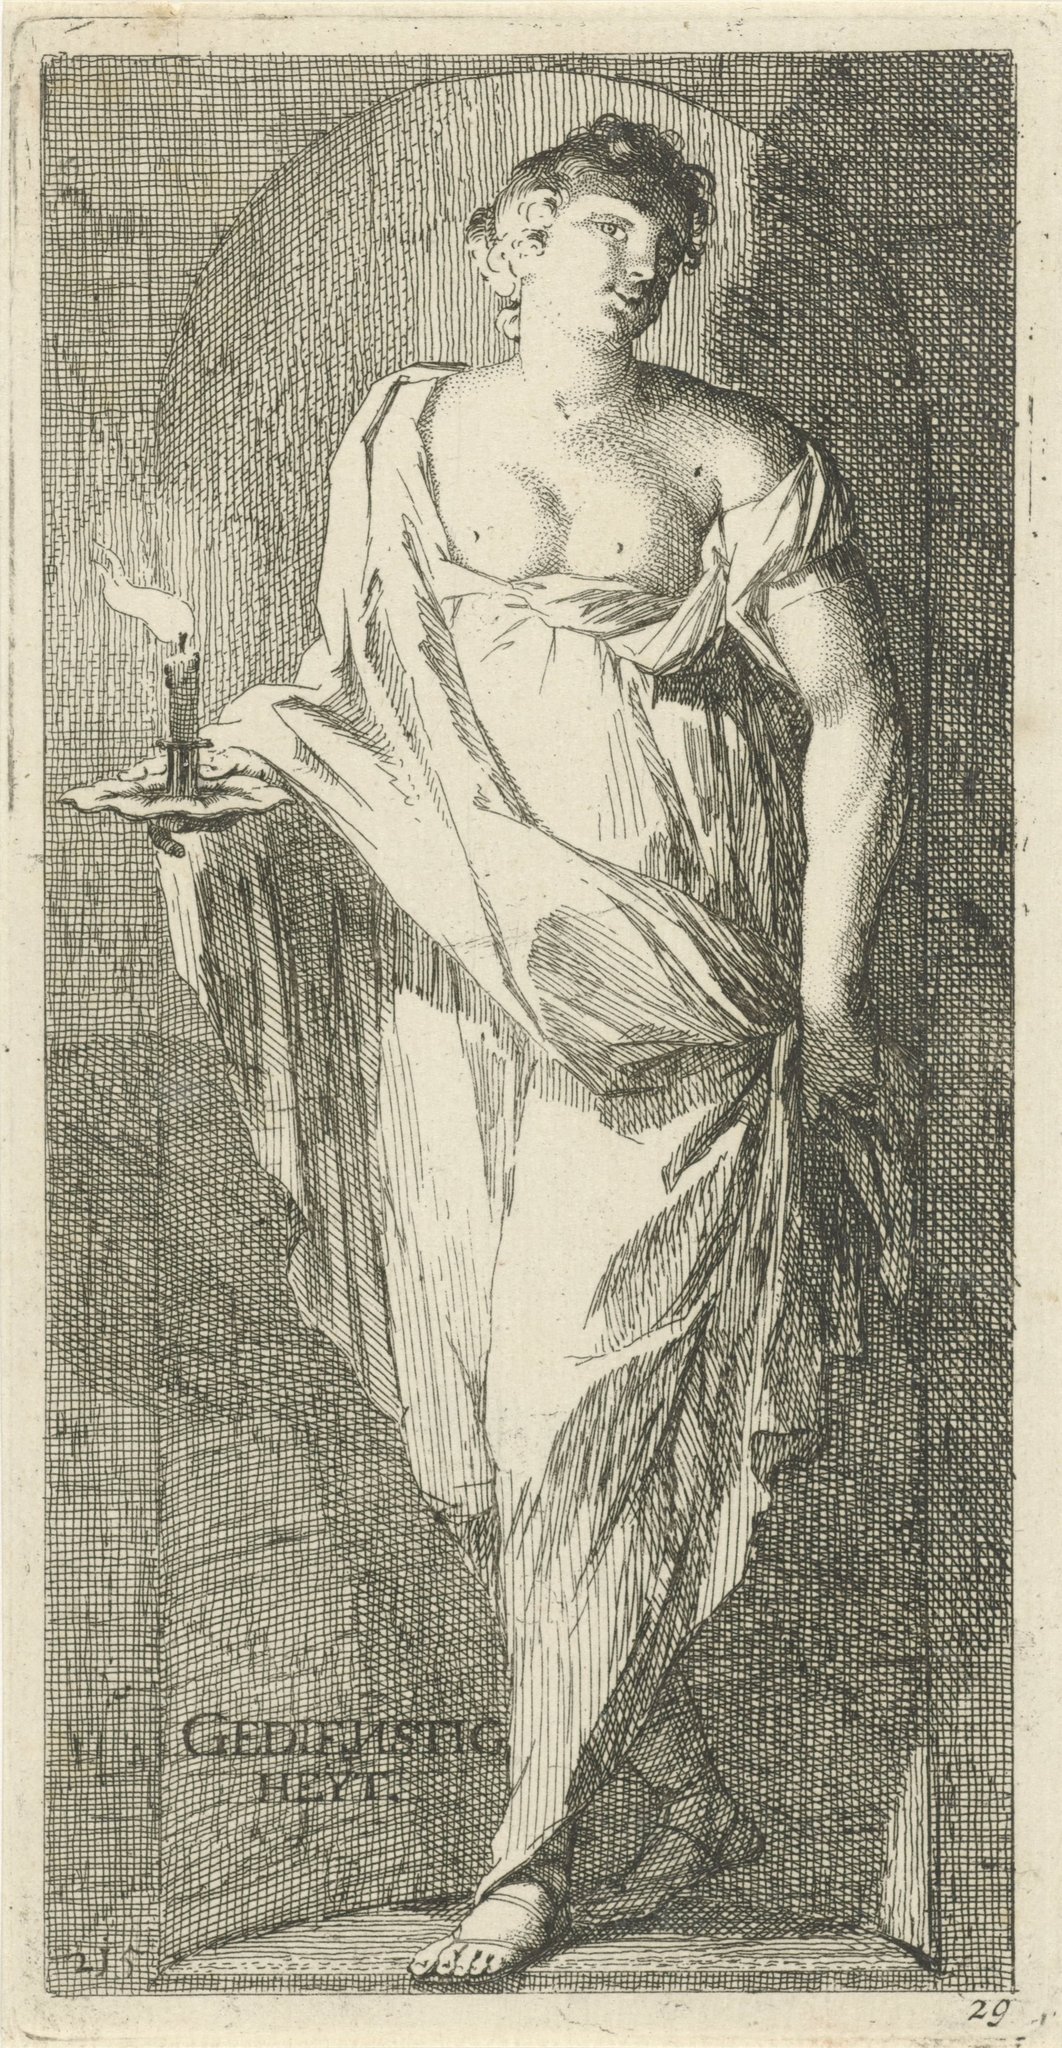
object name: print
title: Personificatie van de gedienstigheid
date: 1710-1719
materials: paper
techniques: etching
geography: amsterdam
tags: candle, darkness, flame, sense of duty, devotion to duty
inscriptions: collector's mark: Lugt 2228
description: Een vrouwfiguur als personificatie van de gedienstigheid in een nis, met in haar rechterhand een kaarsenhouder met een brandende kaars. Prent uit een serie van 41 zinnebeelden.